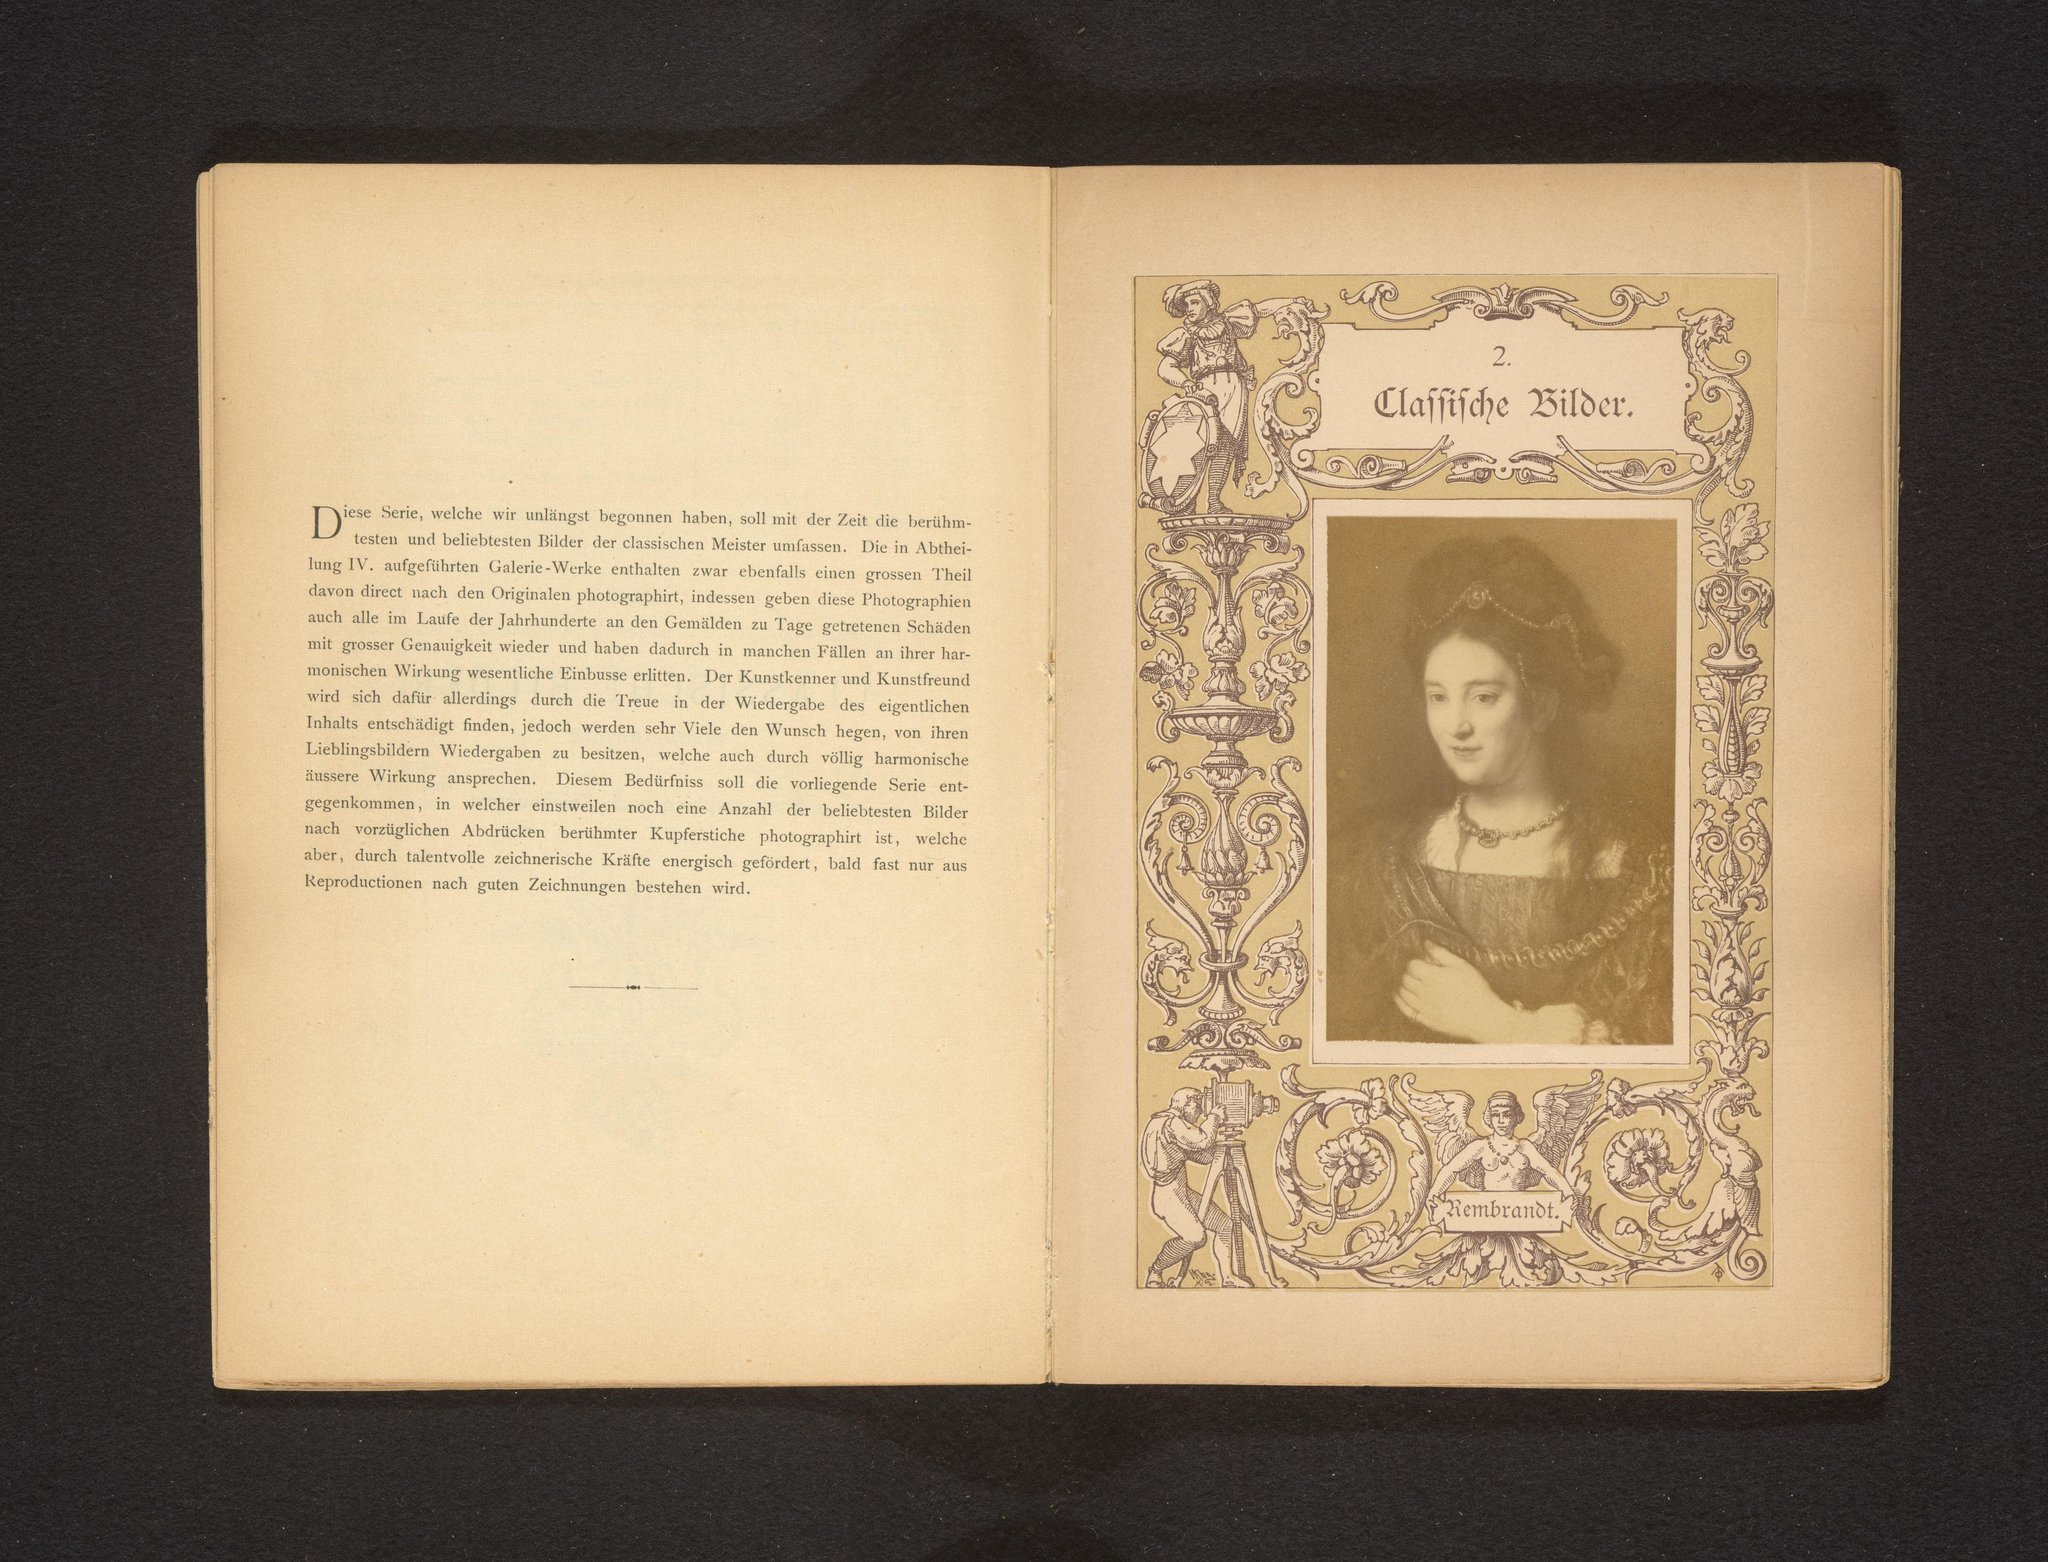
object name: page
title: Rembrandt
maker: rembrandt van rijn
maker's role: draughtsman, painter, print maker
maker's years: 1606-1669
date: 1871-1881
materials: photographic support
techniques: albumen print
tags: adult woman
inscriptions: inscription: ‘2. Classische Bilder.’